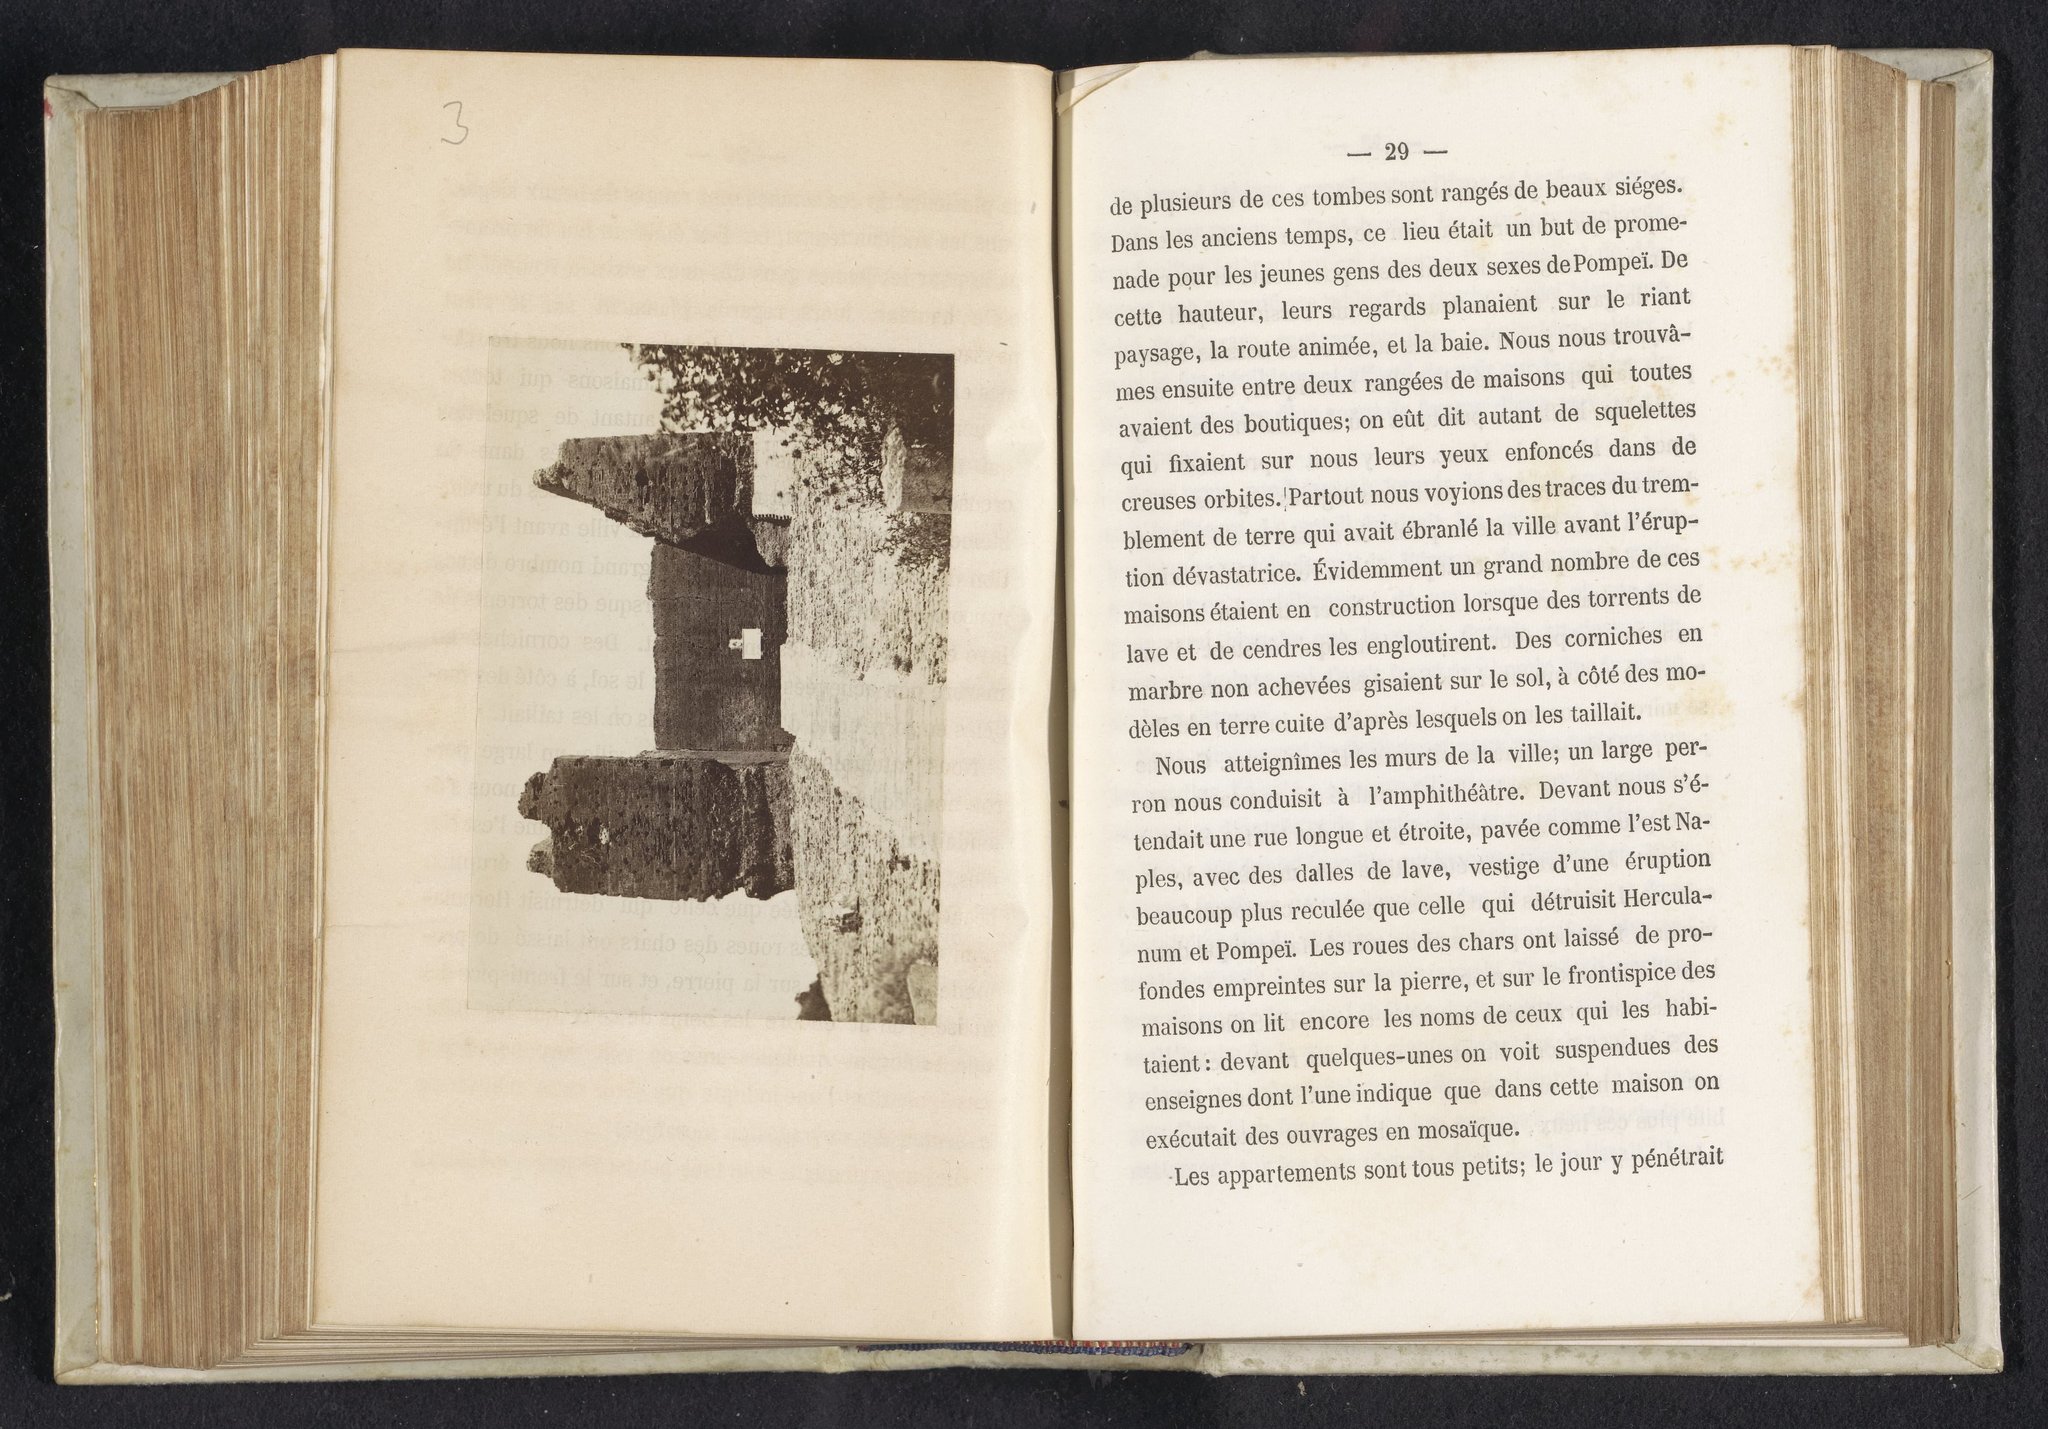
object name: page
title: Gezicht op (vermoedelijk) een deel van de ruïne van het Castello Borgia te Nepi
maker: Anonymous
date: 1850-1860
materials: photographic support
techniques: albumen print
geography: nepi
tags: castle, ruin of a building ~ architecture